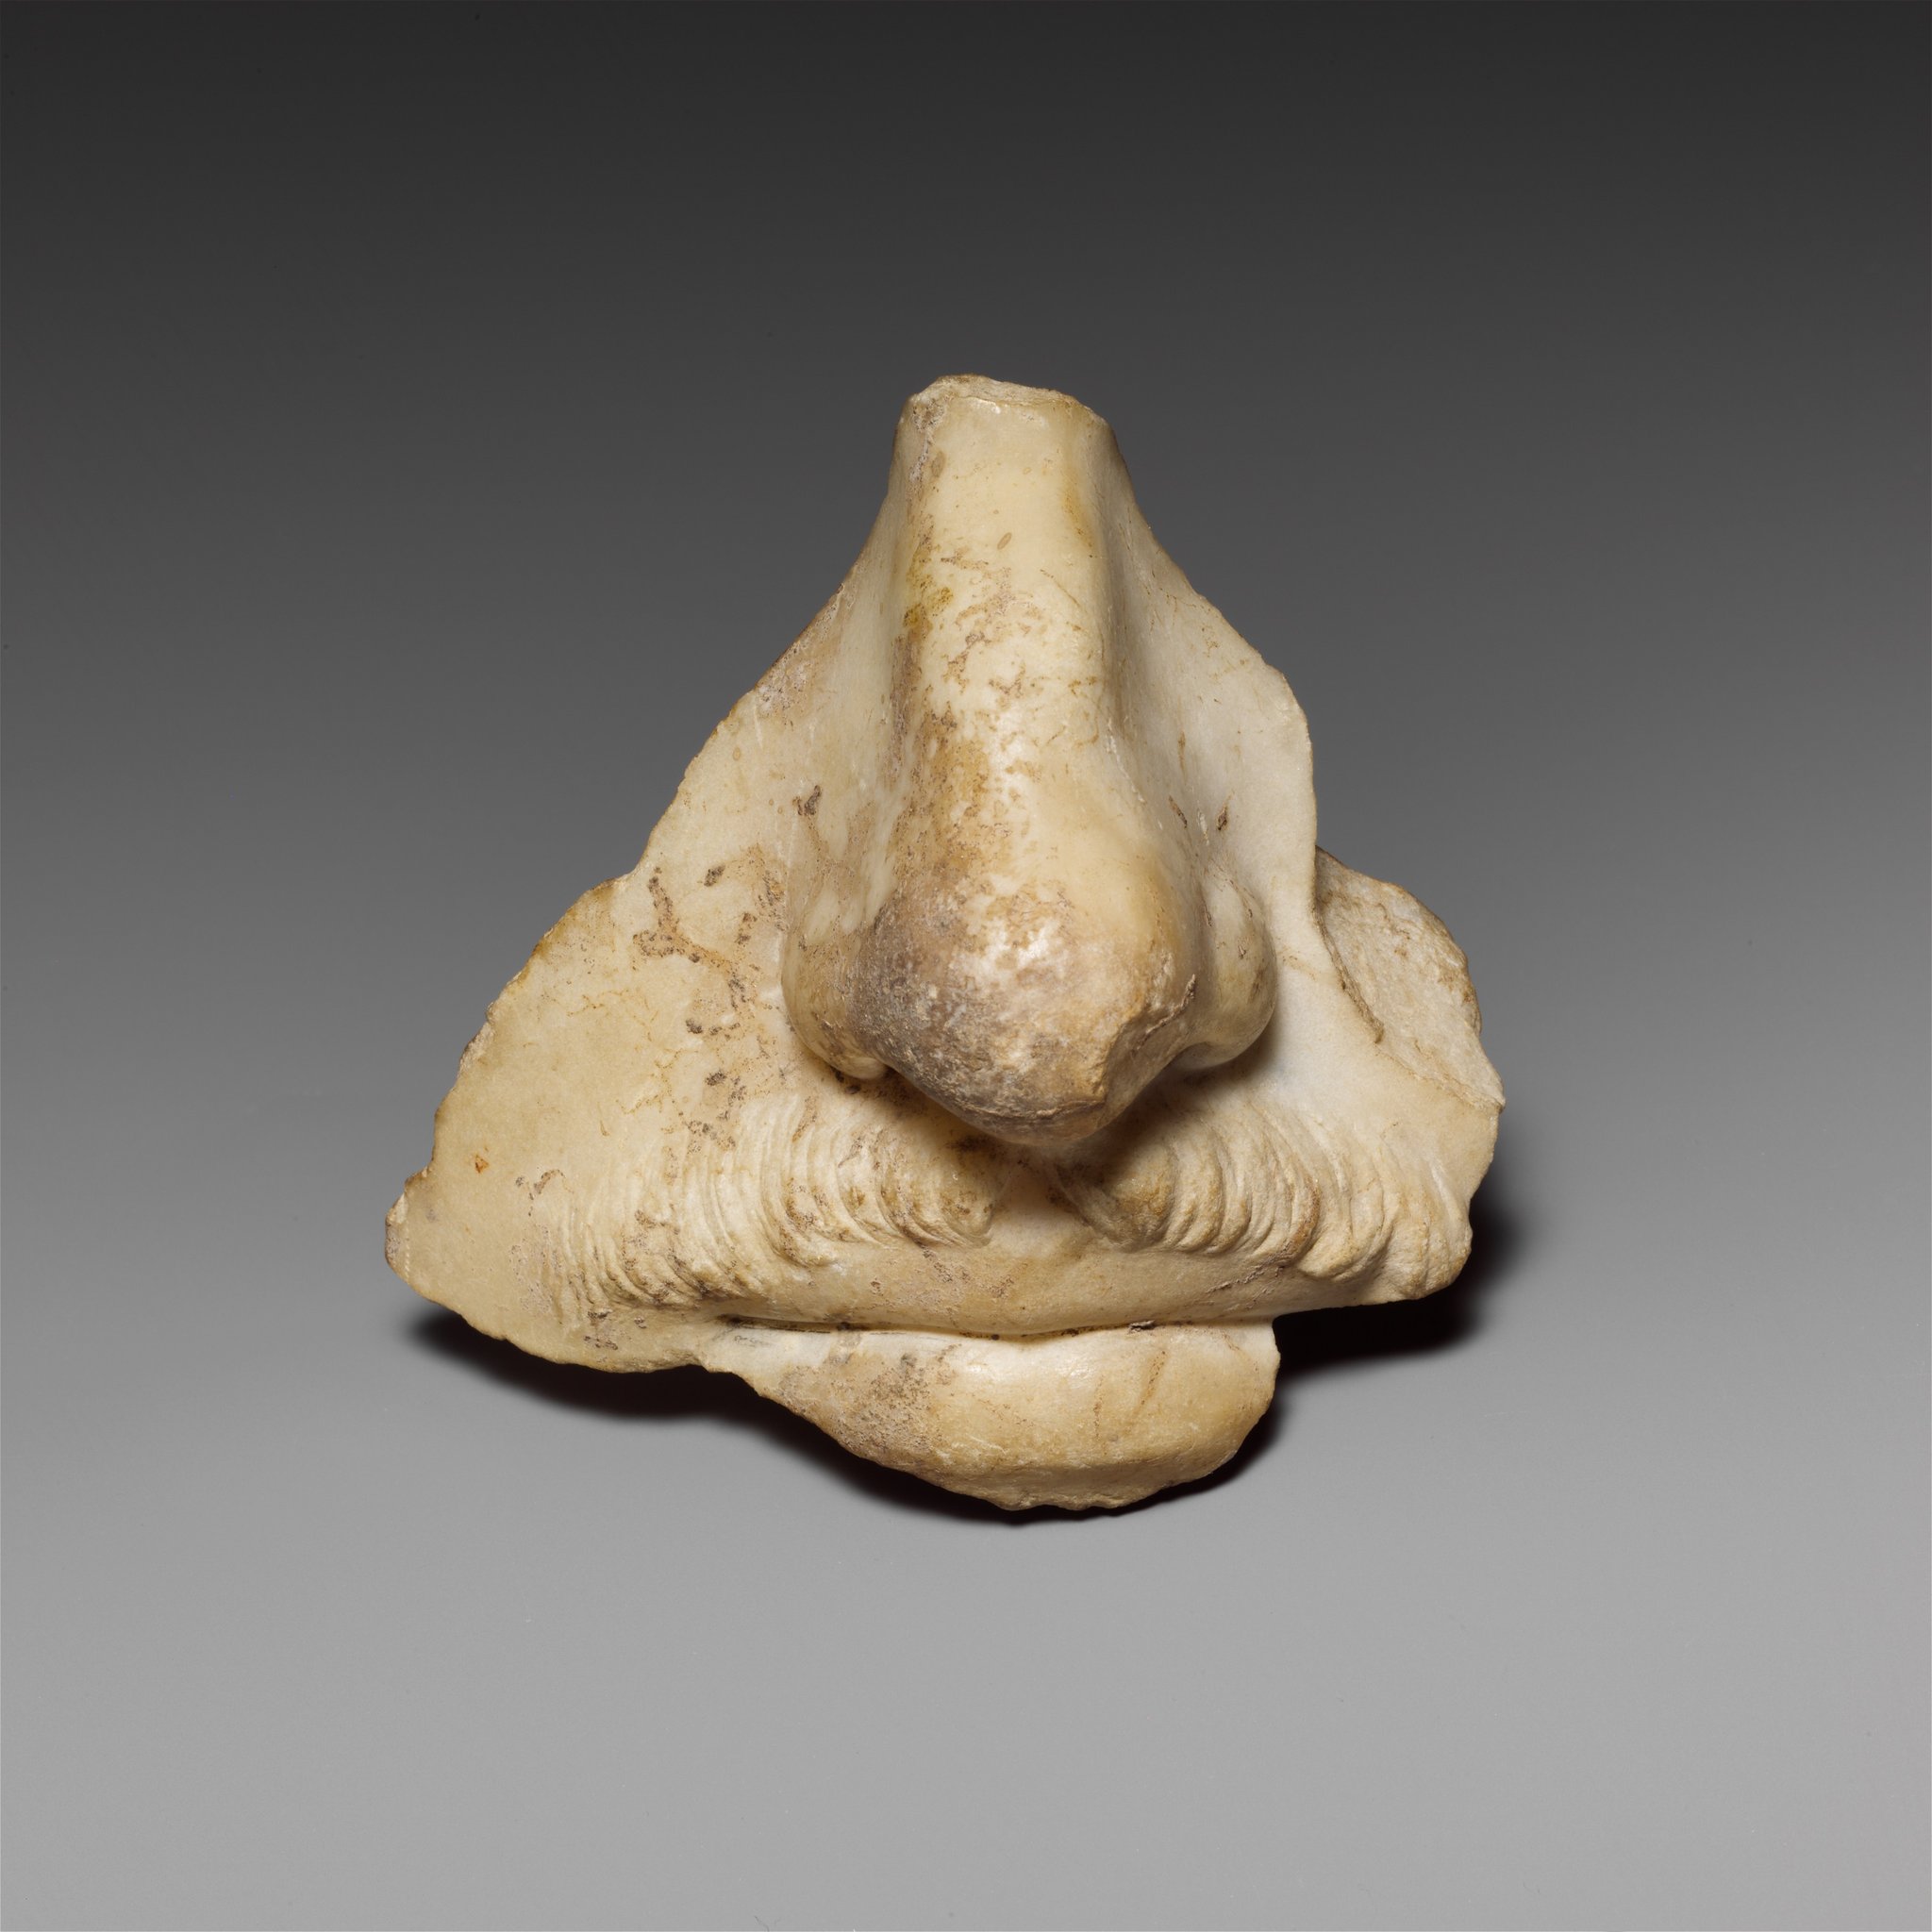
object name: head, fragment, man's nose and mouth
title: Fragment from a marble head of a man, preserving the nose and mouth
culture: roman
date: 134-166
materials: marble